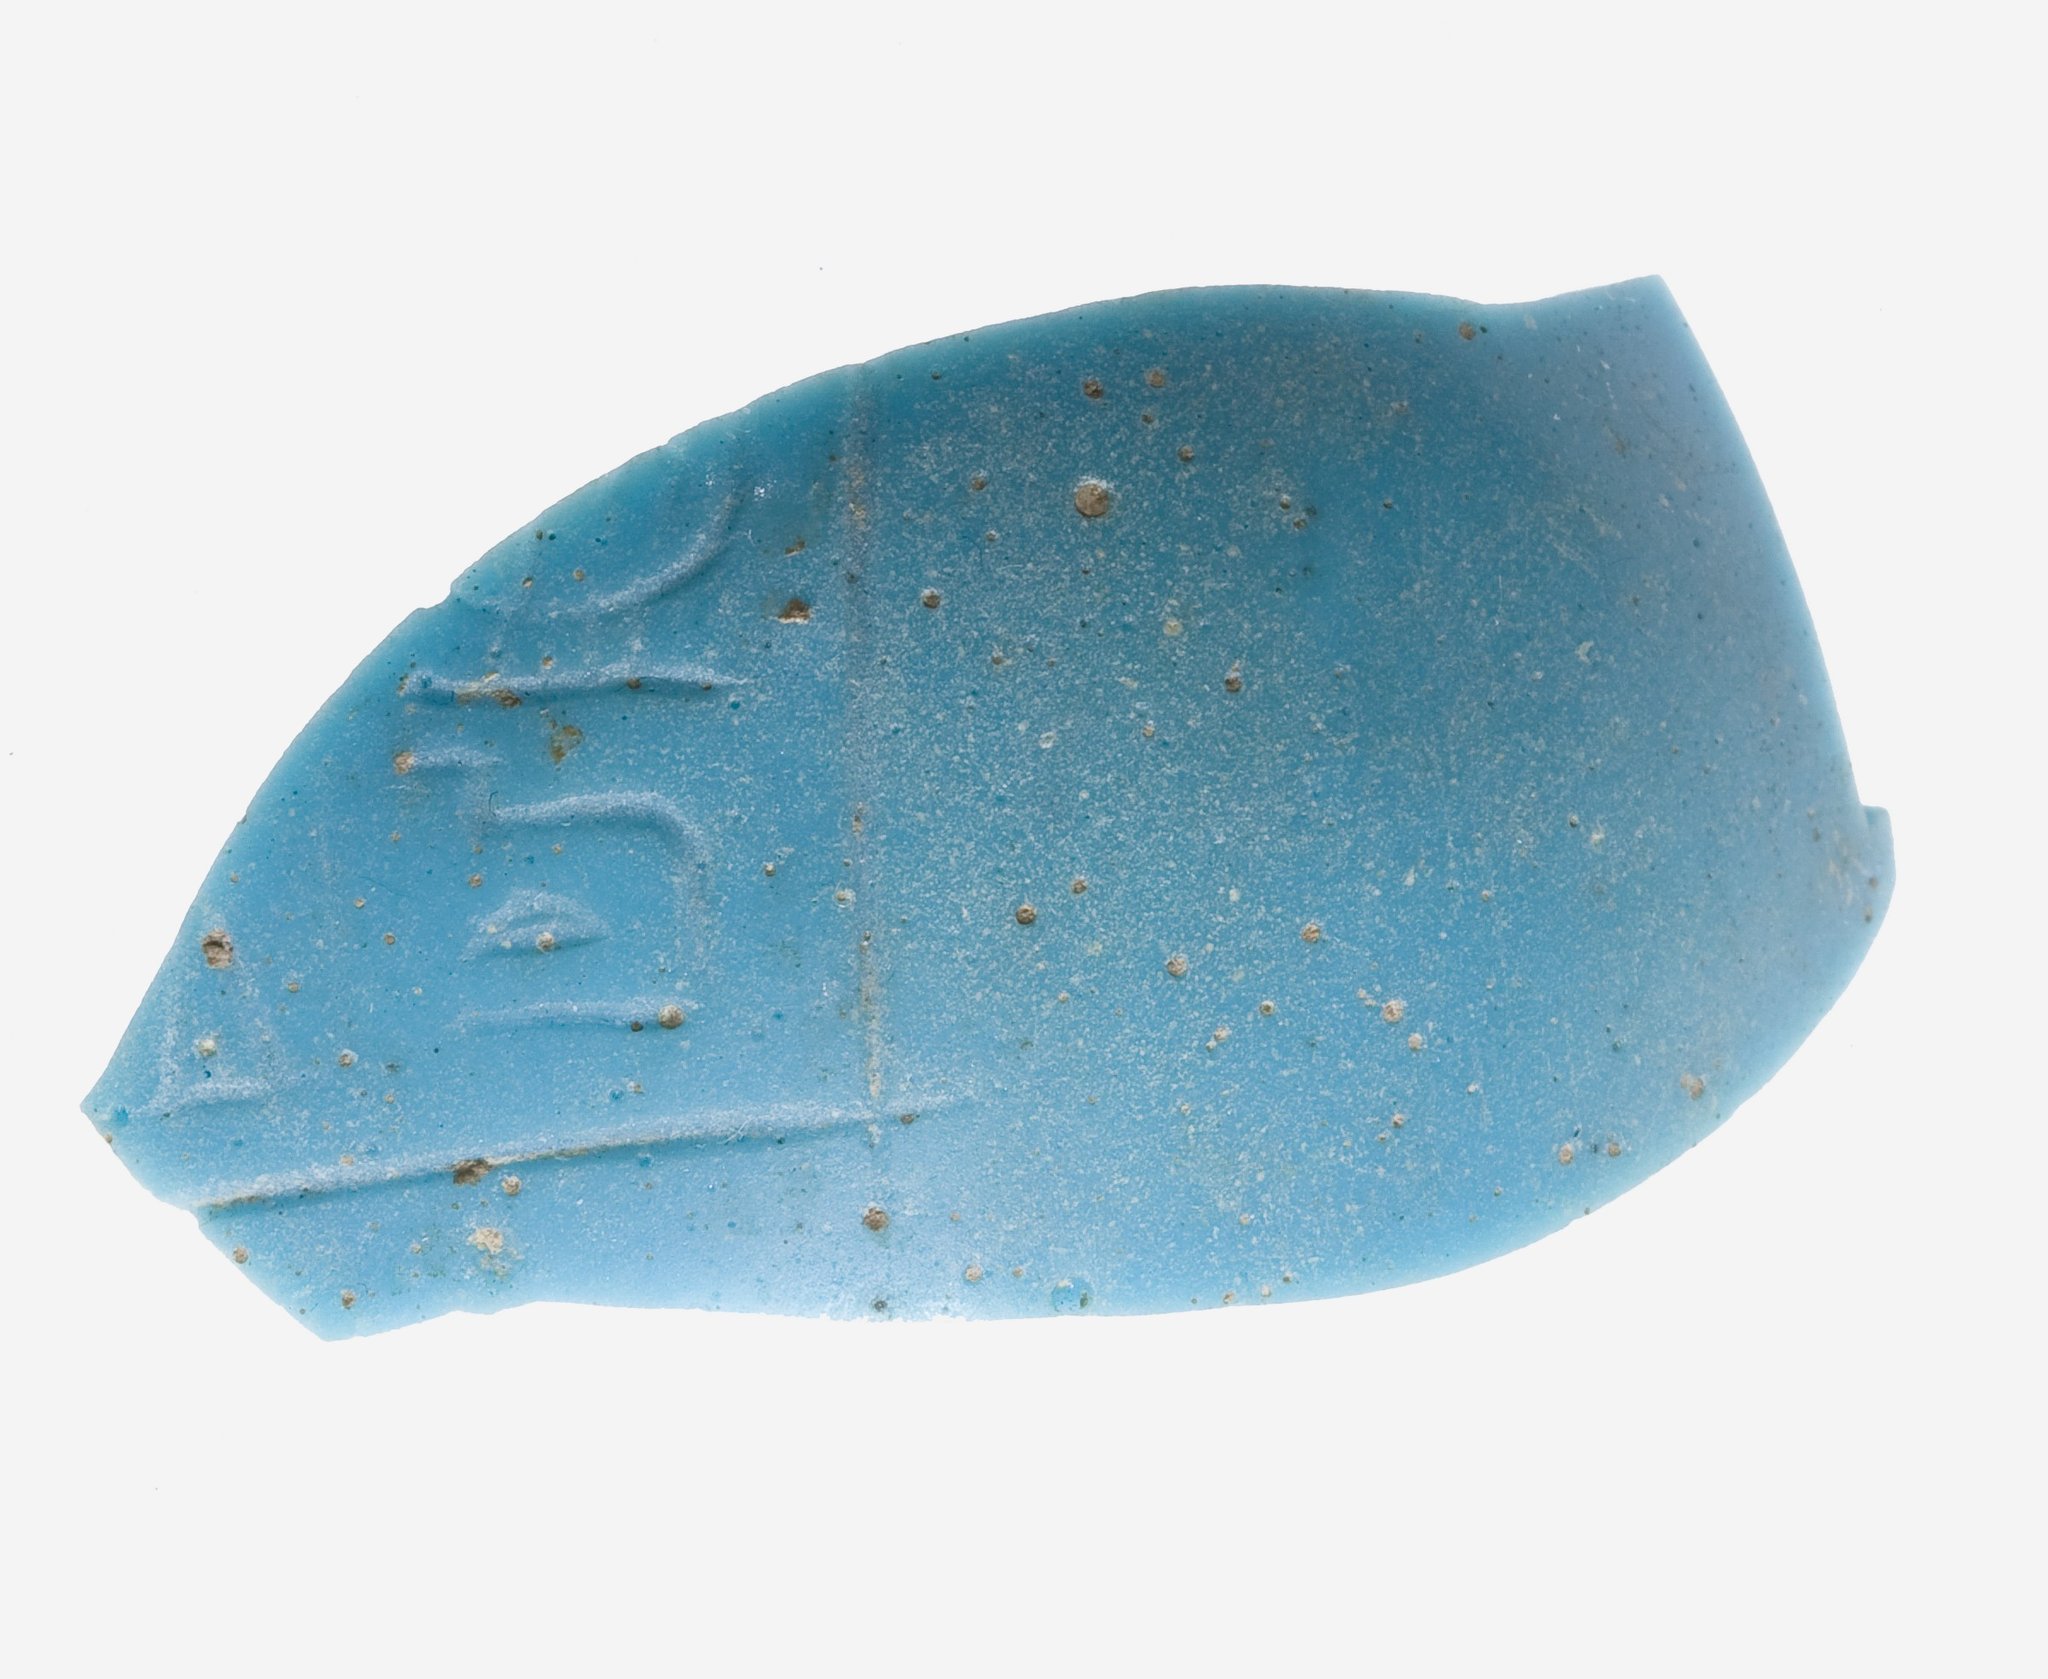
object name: vase, inscription, glass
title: Inscribed Fragment of Vase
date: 1390-1352 BCE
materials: glass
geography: egypt